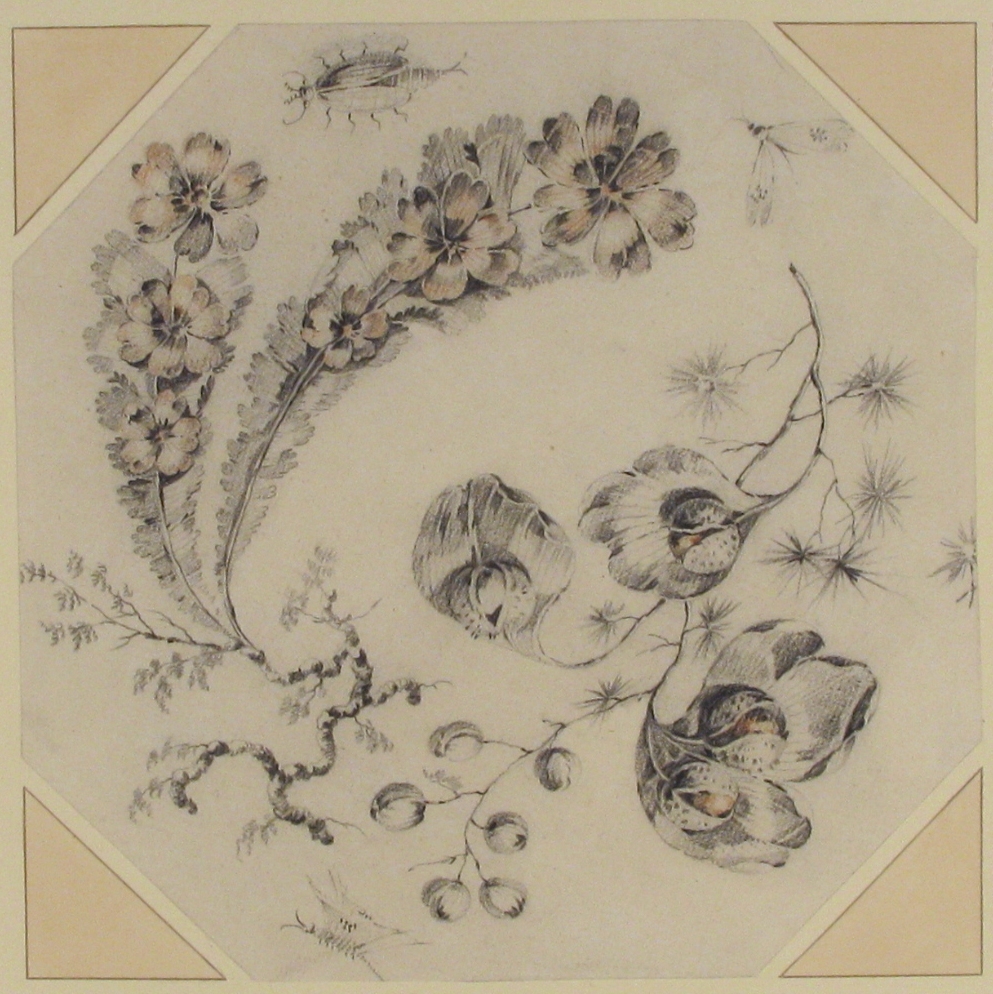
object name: drawing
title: Design for Fantasy Branches of Flowers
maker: jean pillement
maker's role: artist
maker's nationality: french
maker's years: 1728-1808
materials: chalk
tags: insects,flowers,leaves